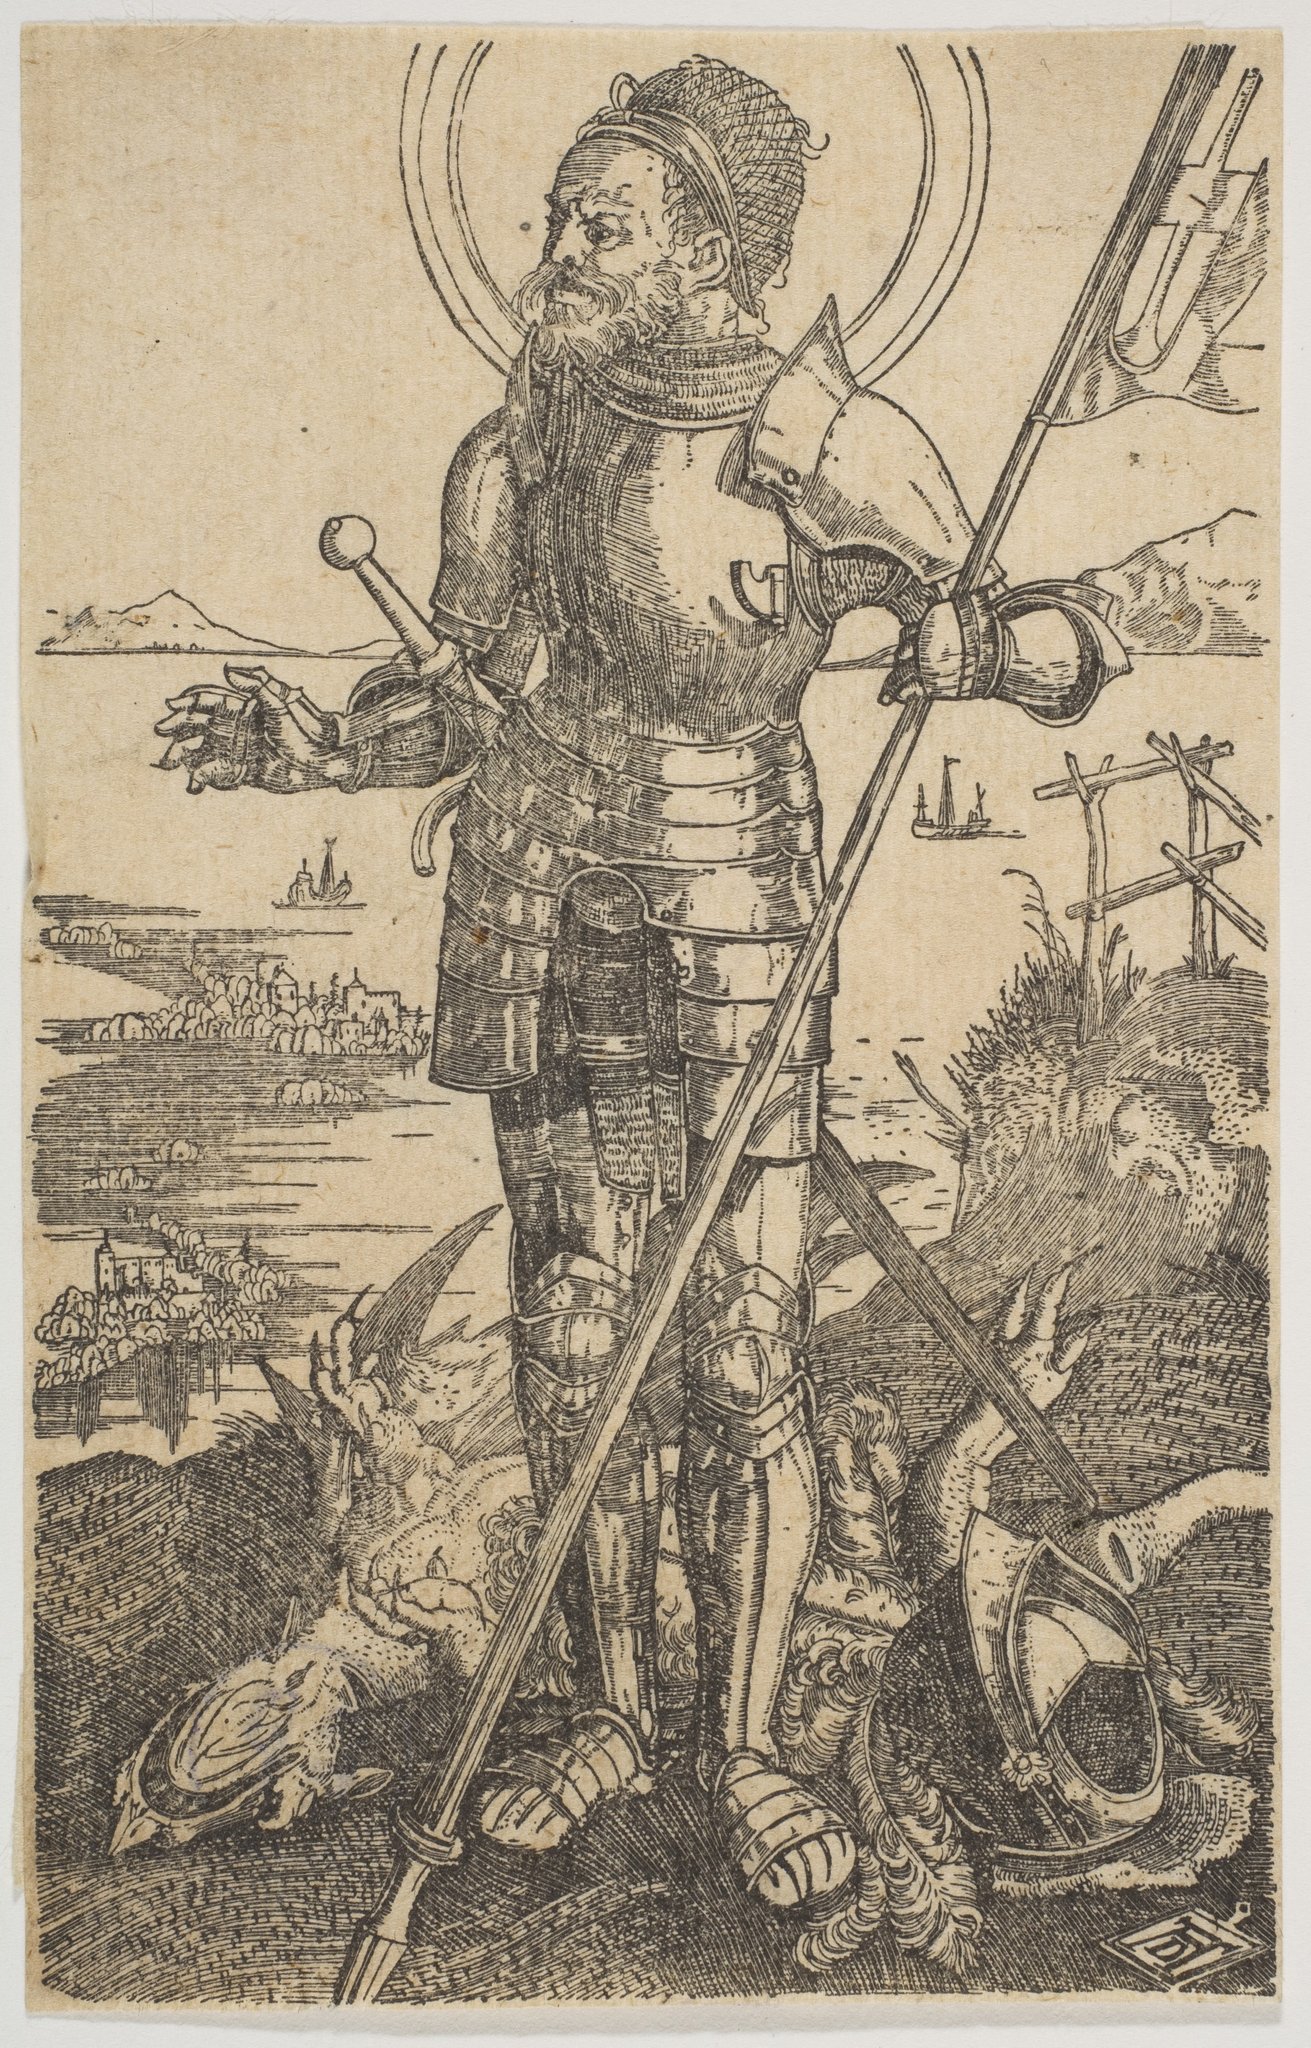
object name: print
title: Saint George Standing (copy)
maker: albrecht dürer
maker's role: artist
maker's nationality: german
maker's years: 1471-1528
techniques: engraving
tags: saint george,flags